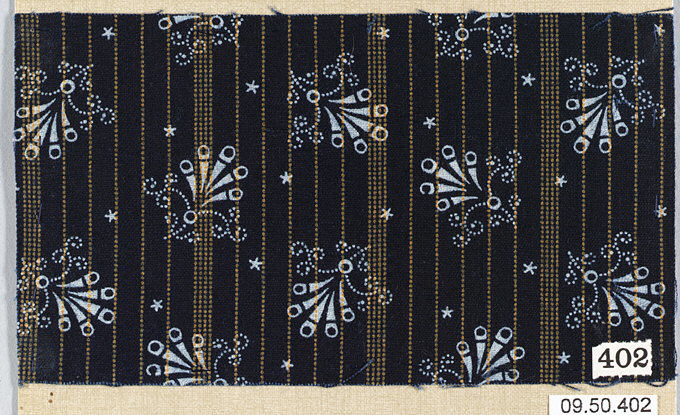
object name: piece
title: Piece (one of 116)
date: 1801-1900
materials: cotton